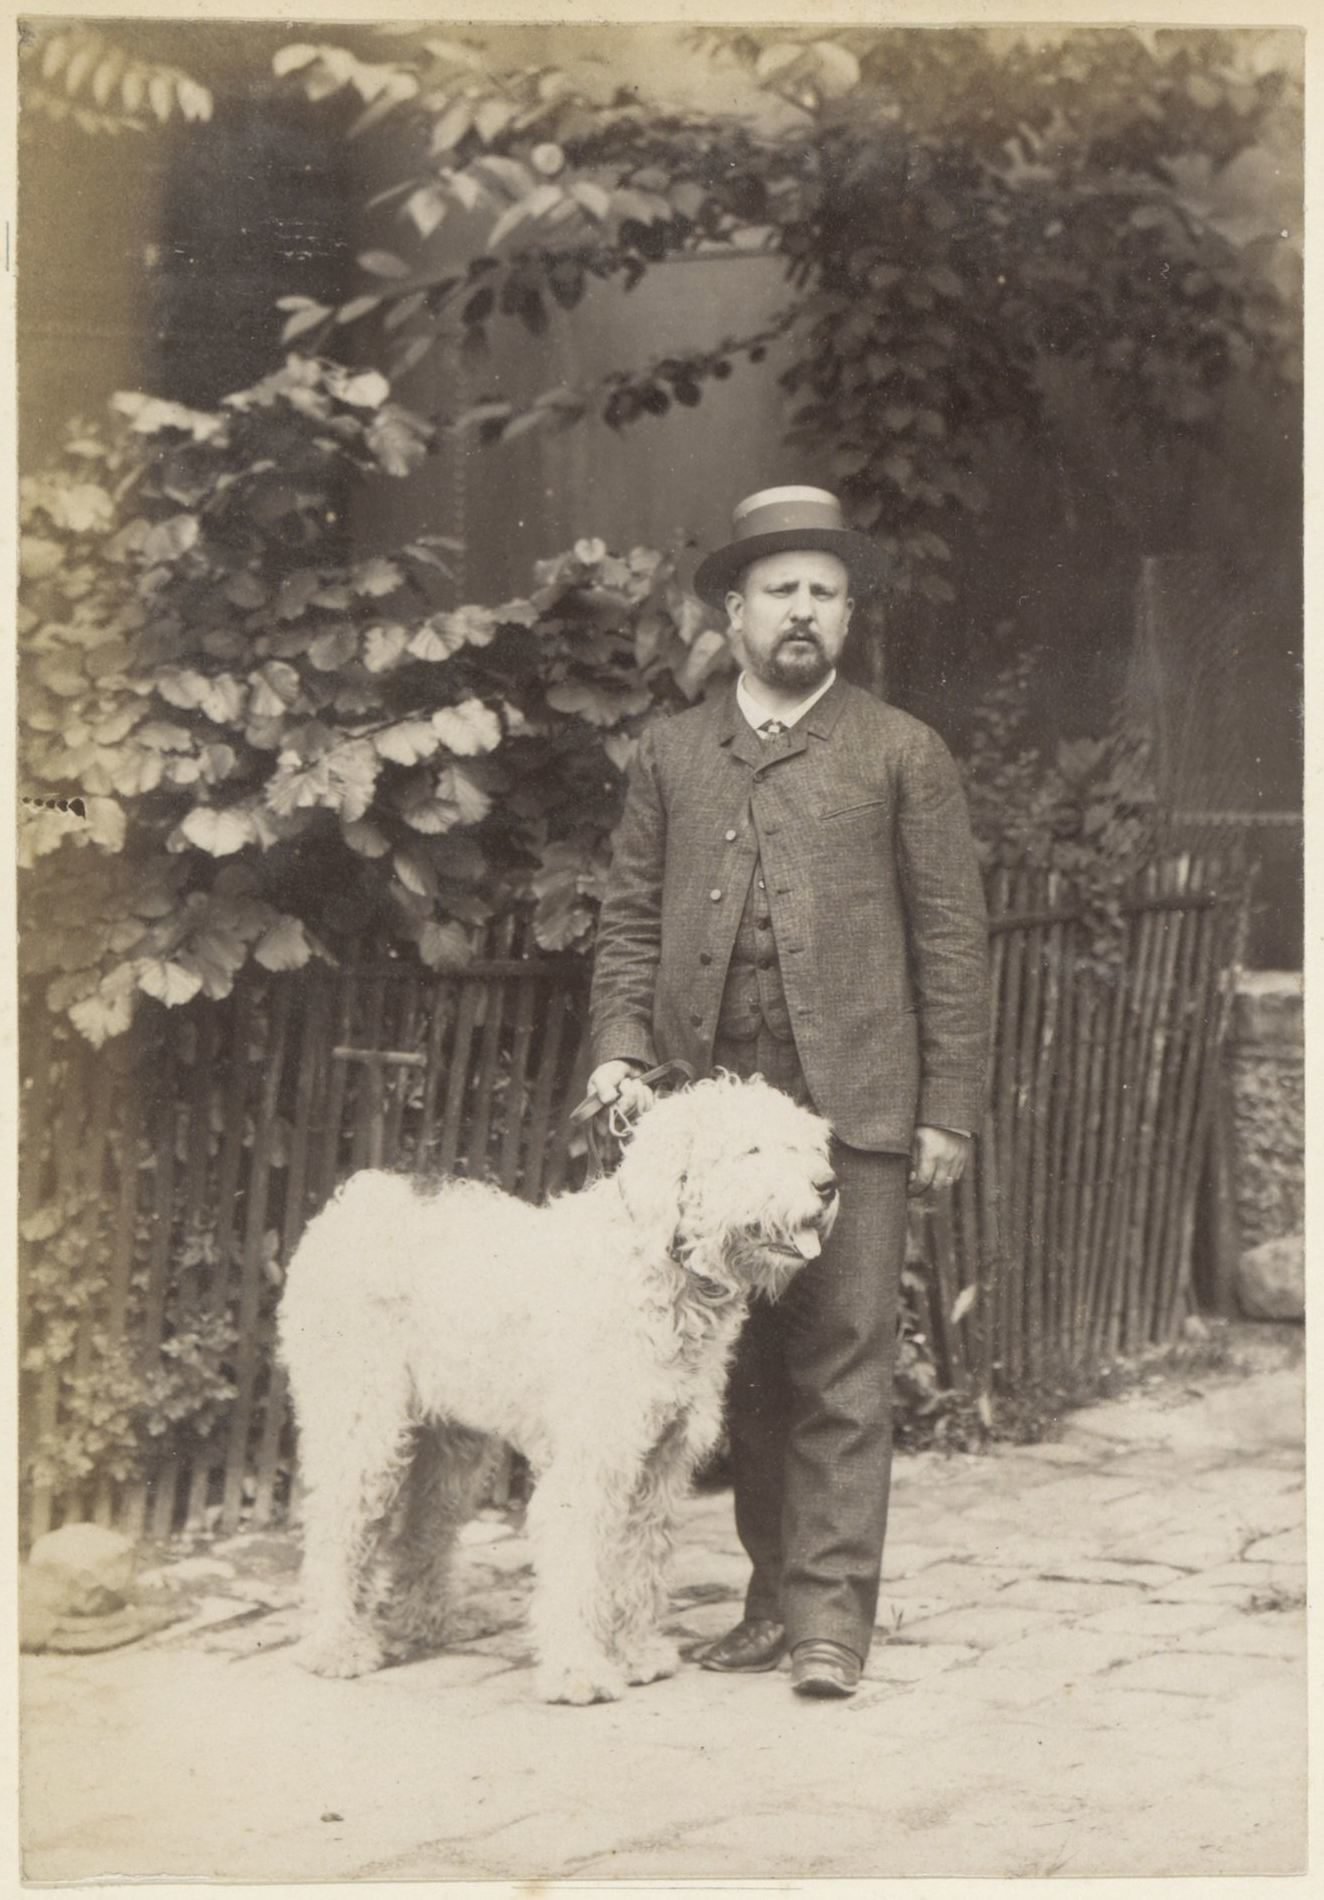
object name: photograph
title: Portret van een man met een hond in Frankrijk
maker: Anonymous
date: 1900-1910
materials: paper, photographic support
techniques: albumen print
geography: france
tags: fence, wall, paling, adult man, dog, france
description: Onderdeel van Fotoalbum van een Franse amateurfotograaf met opnames van een familie, distilleerderij Delizy & Doistau Fils, het leger en bezienswaardigheden in Frankrijk.